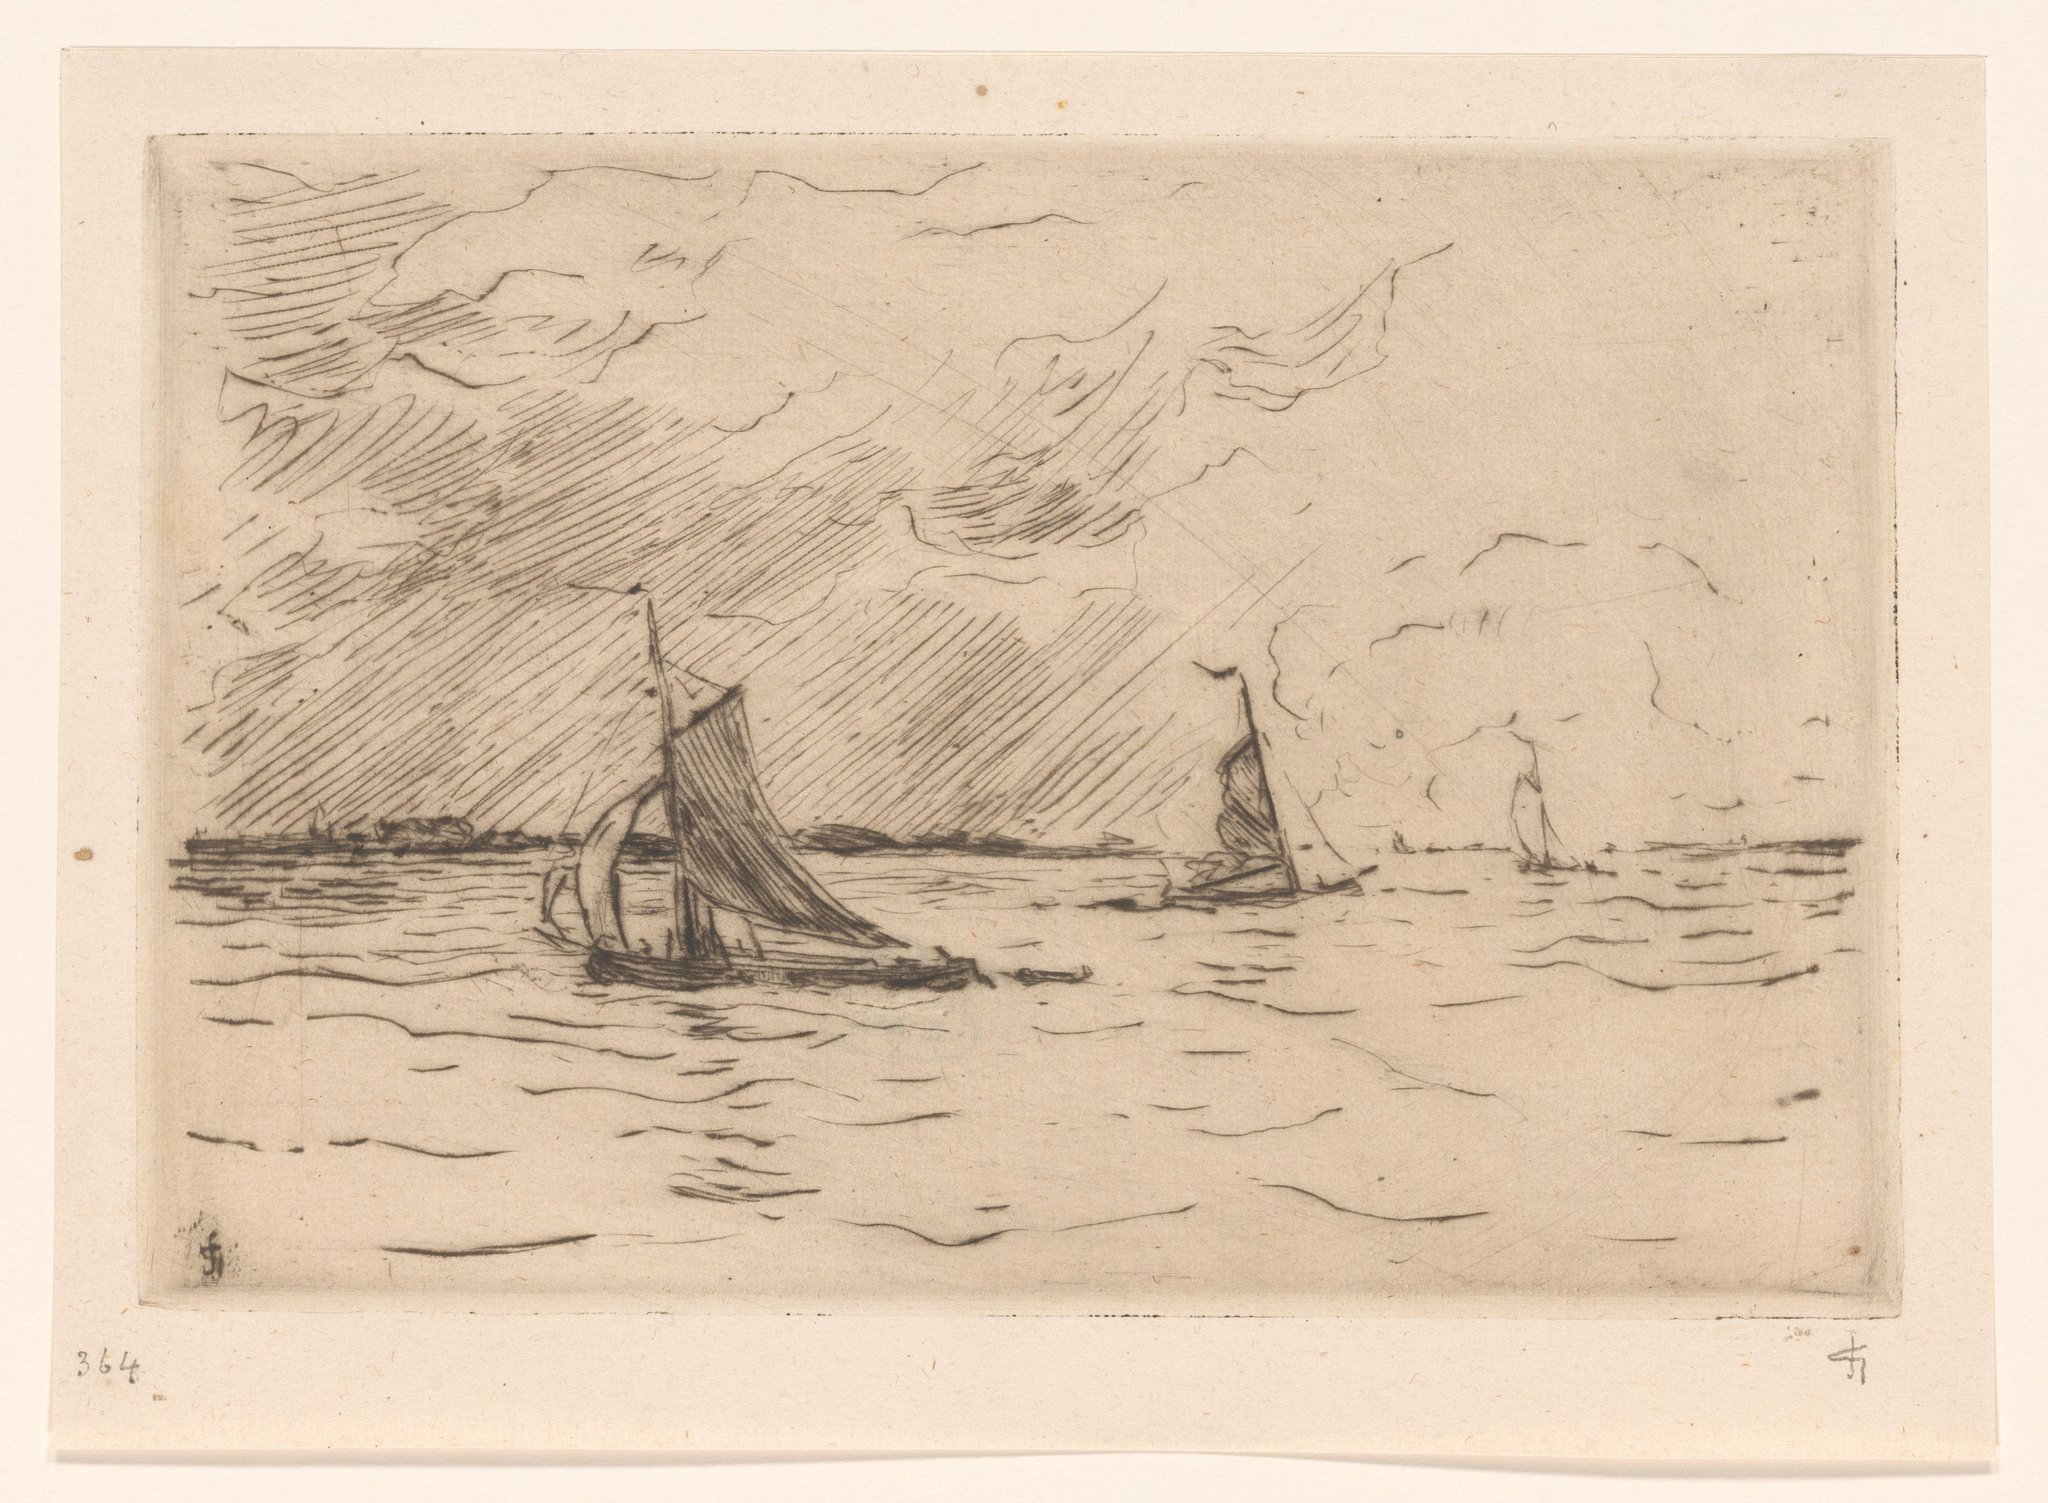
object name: print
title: Drie zeilboten op de Maas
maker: carel nicolaas storm van s-gravesande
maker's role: draughtsman, print maker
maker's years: 1841-1924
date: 1889-1902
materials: paper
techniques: drypoint, intaglio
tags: sailing-ship, sailing-boat, river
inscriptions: number: ‘364’, collector's mark: Lugt 2228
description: Mogelijk vermeld in: Storm van 's-Gravesande, Charles. Catalogue des eaux-fortes et lithographies. New York: s.n., 1903, of in een onbekende latere uitgave van het manuscript. Vermoedelijk vermeld als catalogusnummer 364.